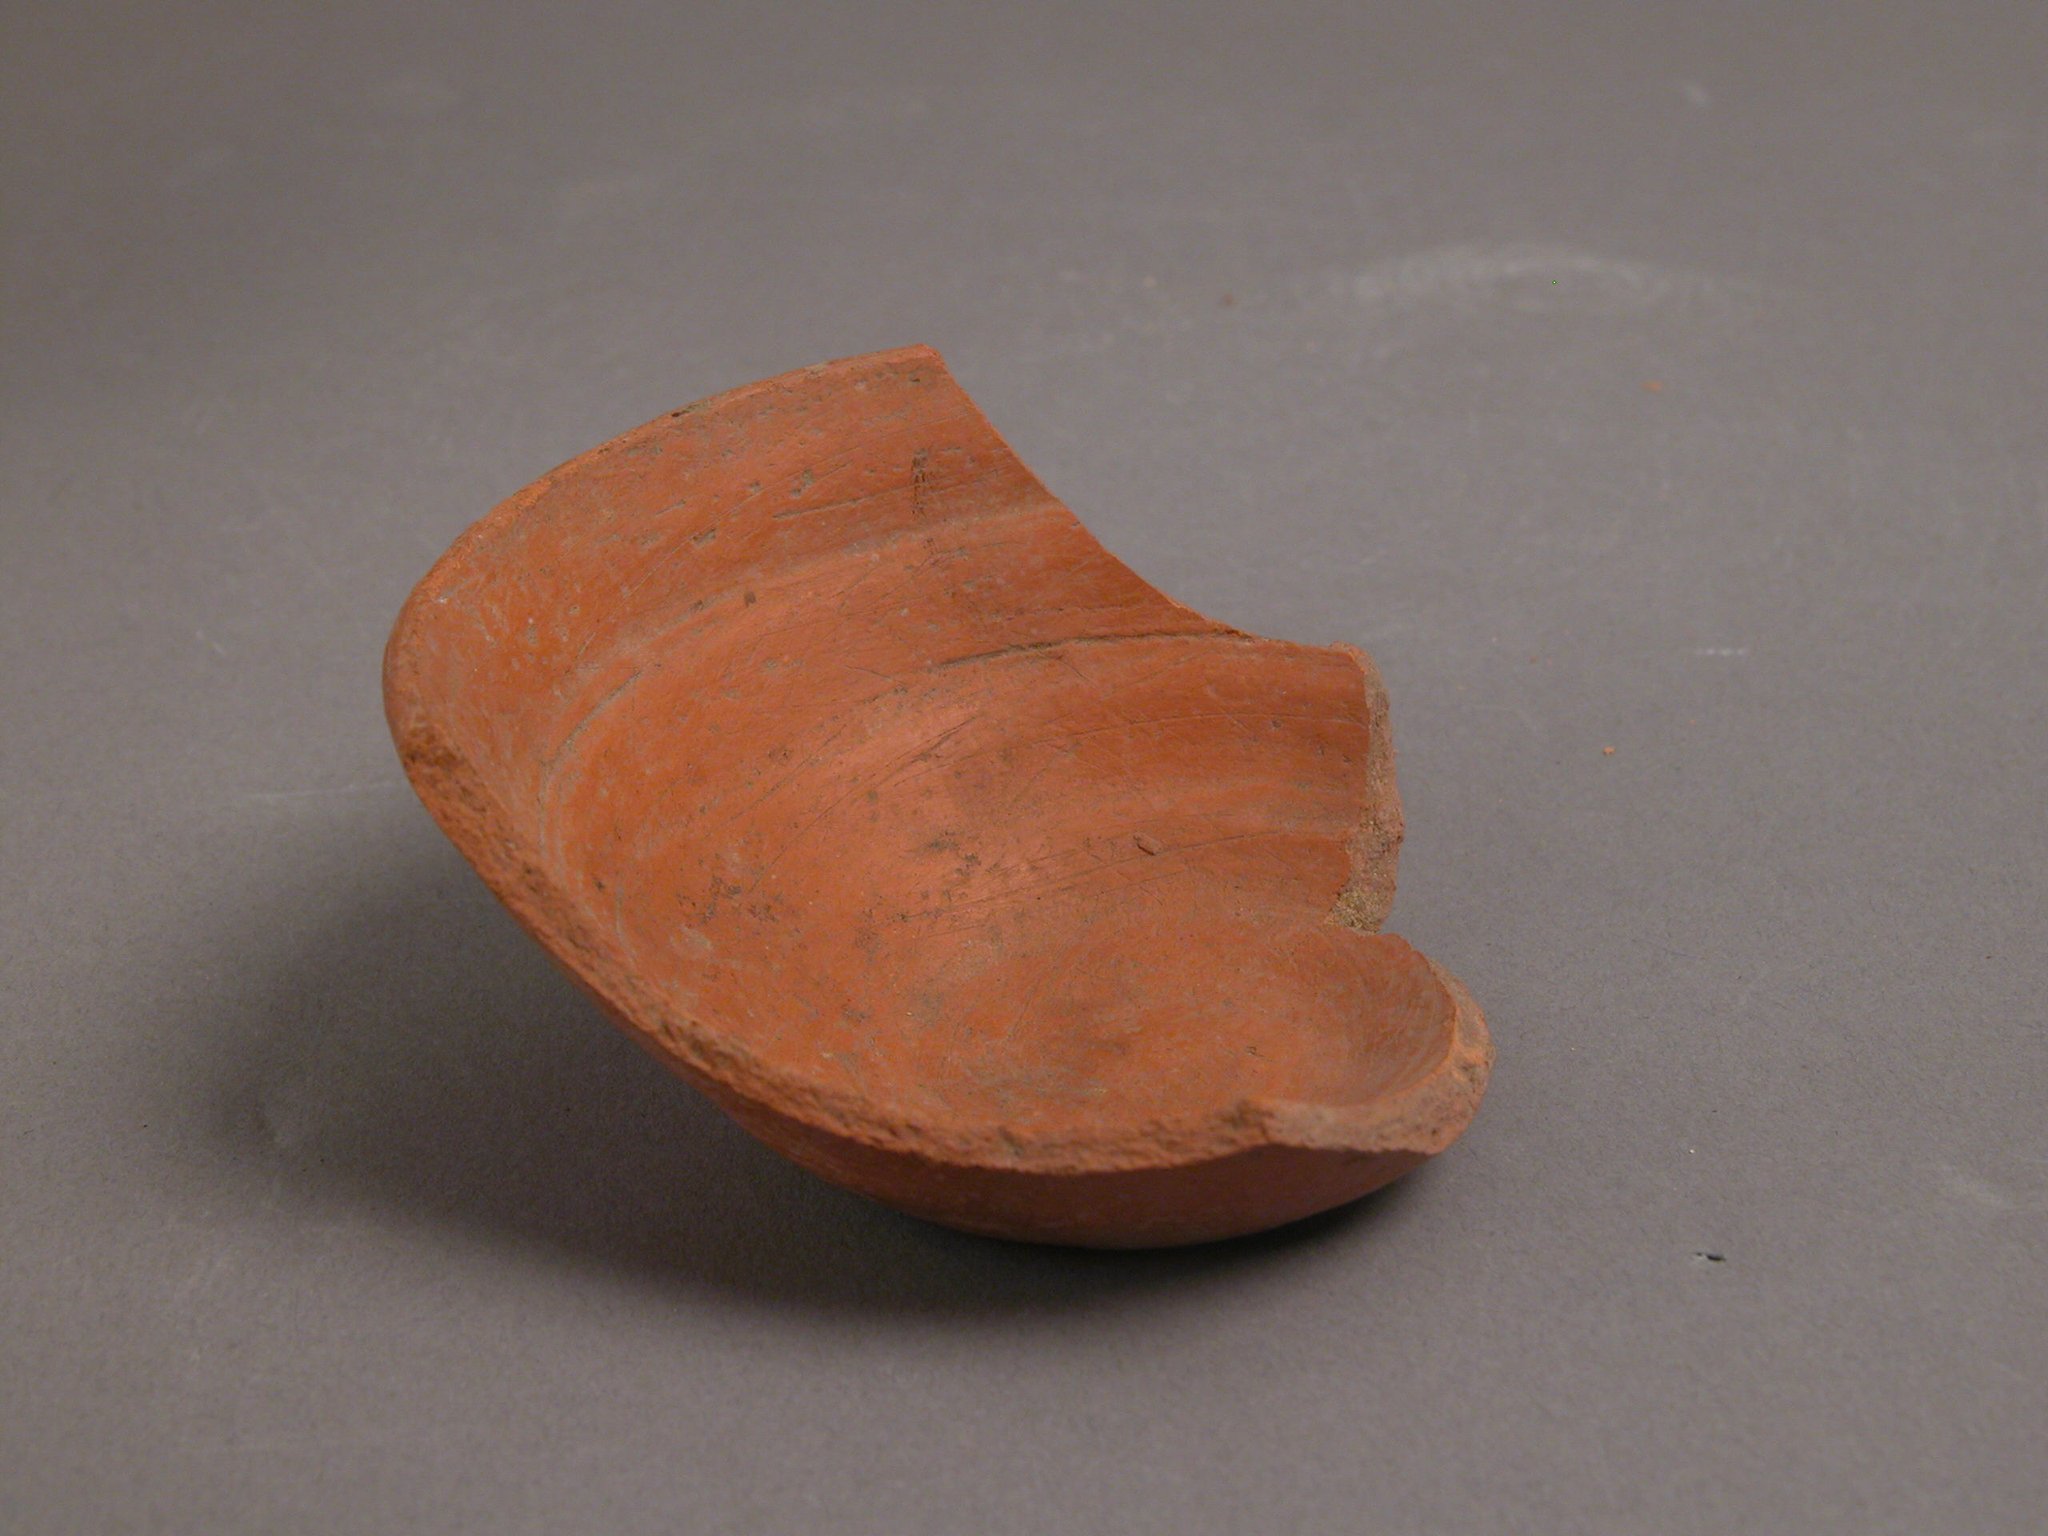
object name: fragment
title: Bowl Fragment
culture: coptic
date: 301-700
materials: earthenware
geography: egypt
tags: bowls